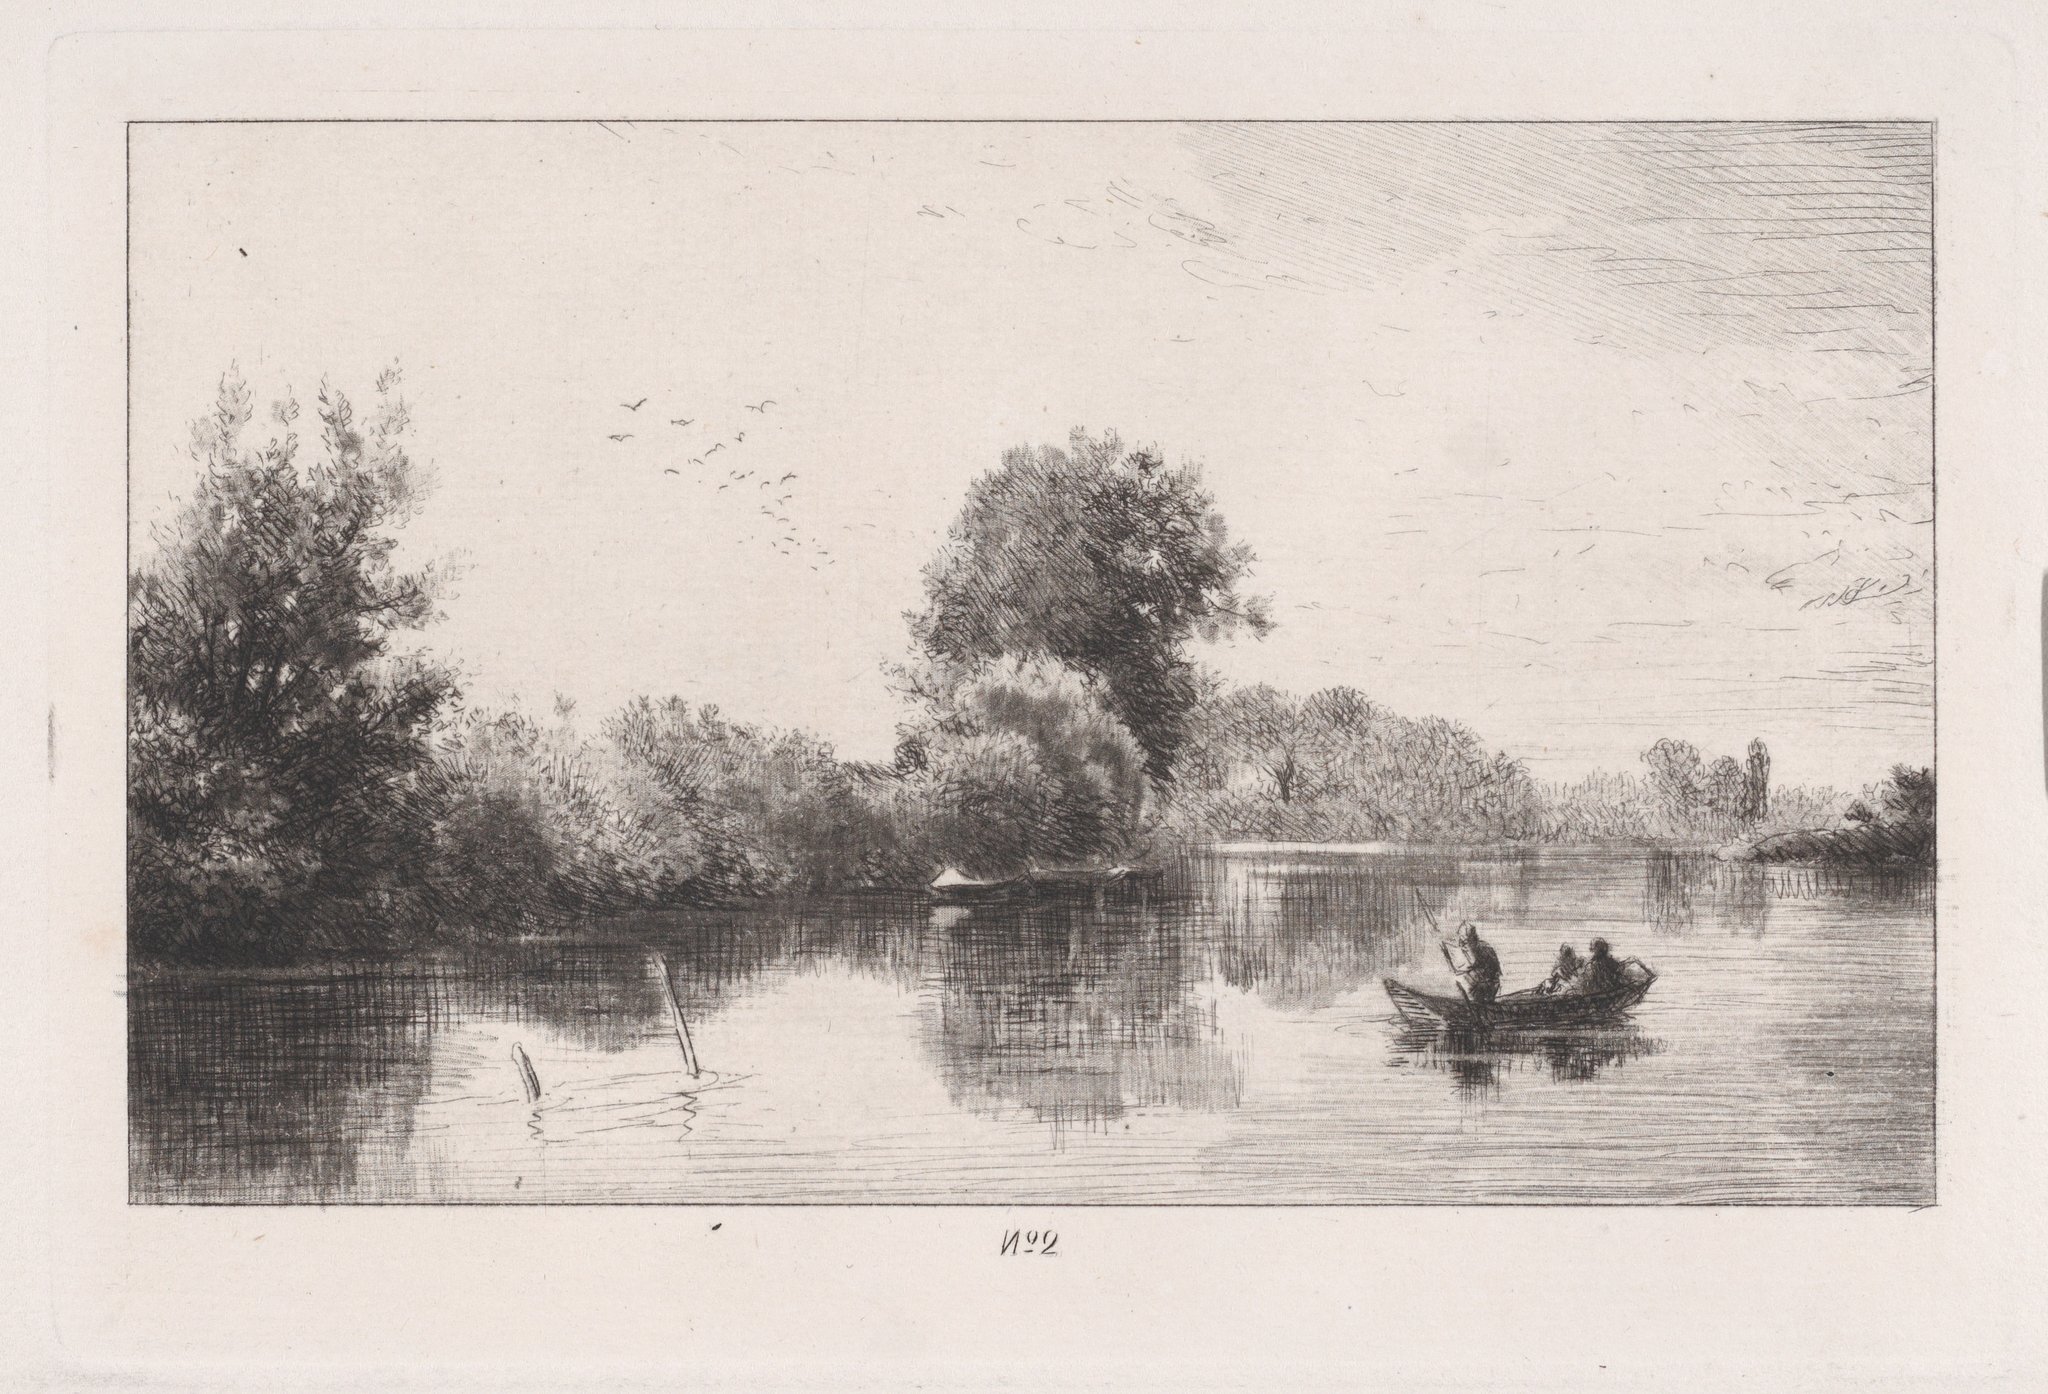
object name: print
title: Bords de la Marne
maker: charles émile jacque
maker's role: artist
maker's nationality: french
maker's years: 1813-1894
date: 1862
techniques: drypoint